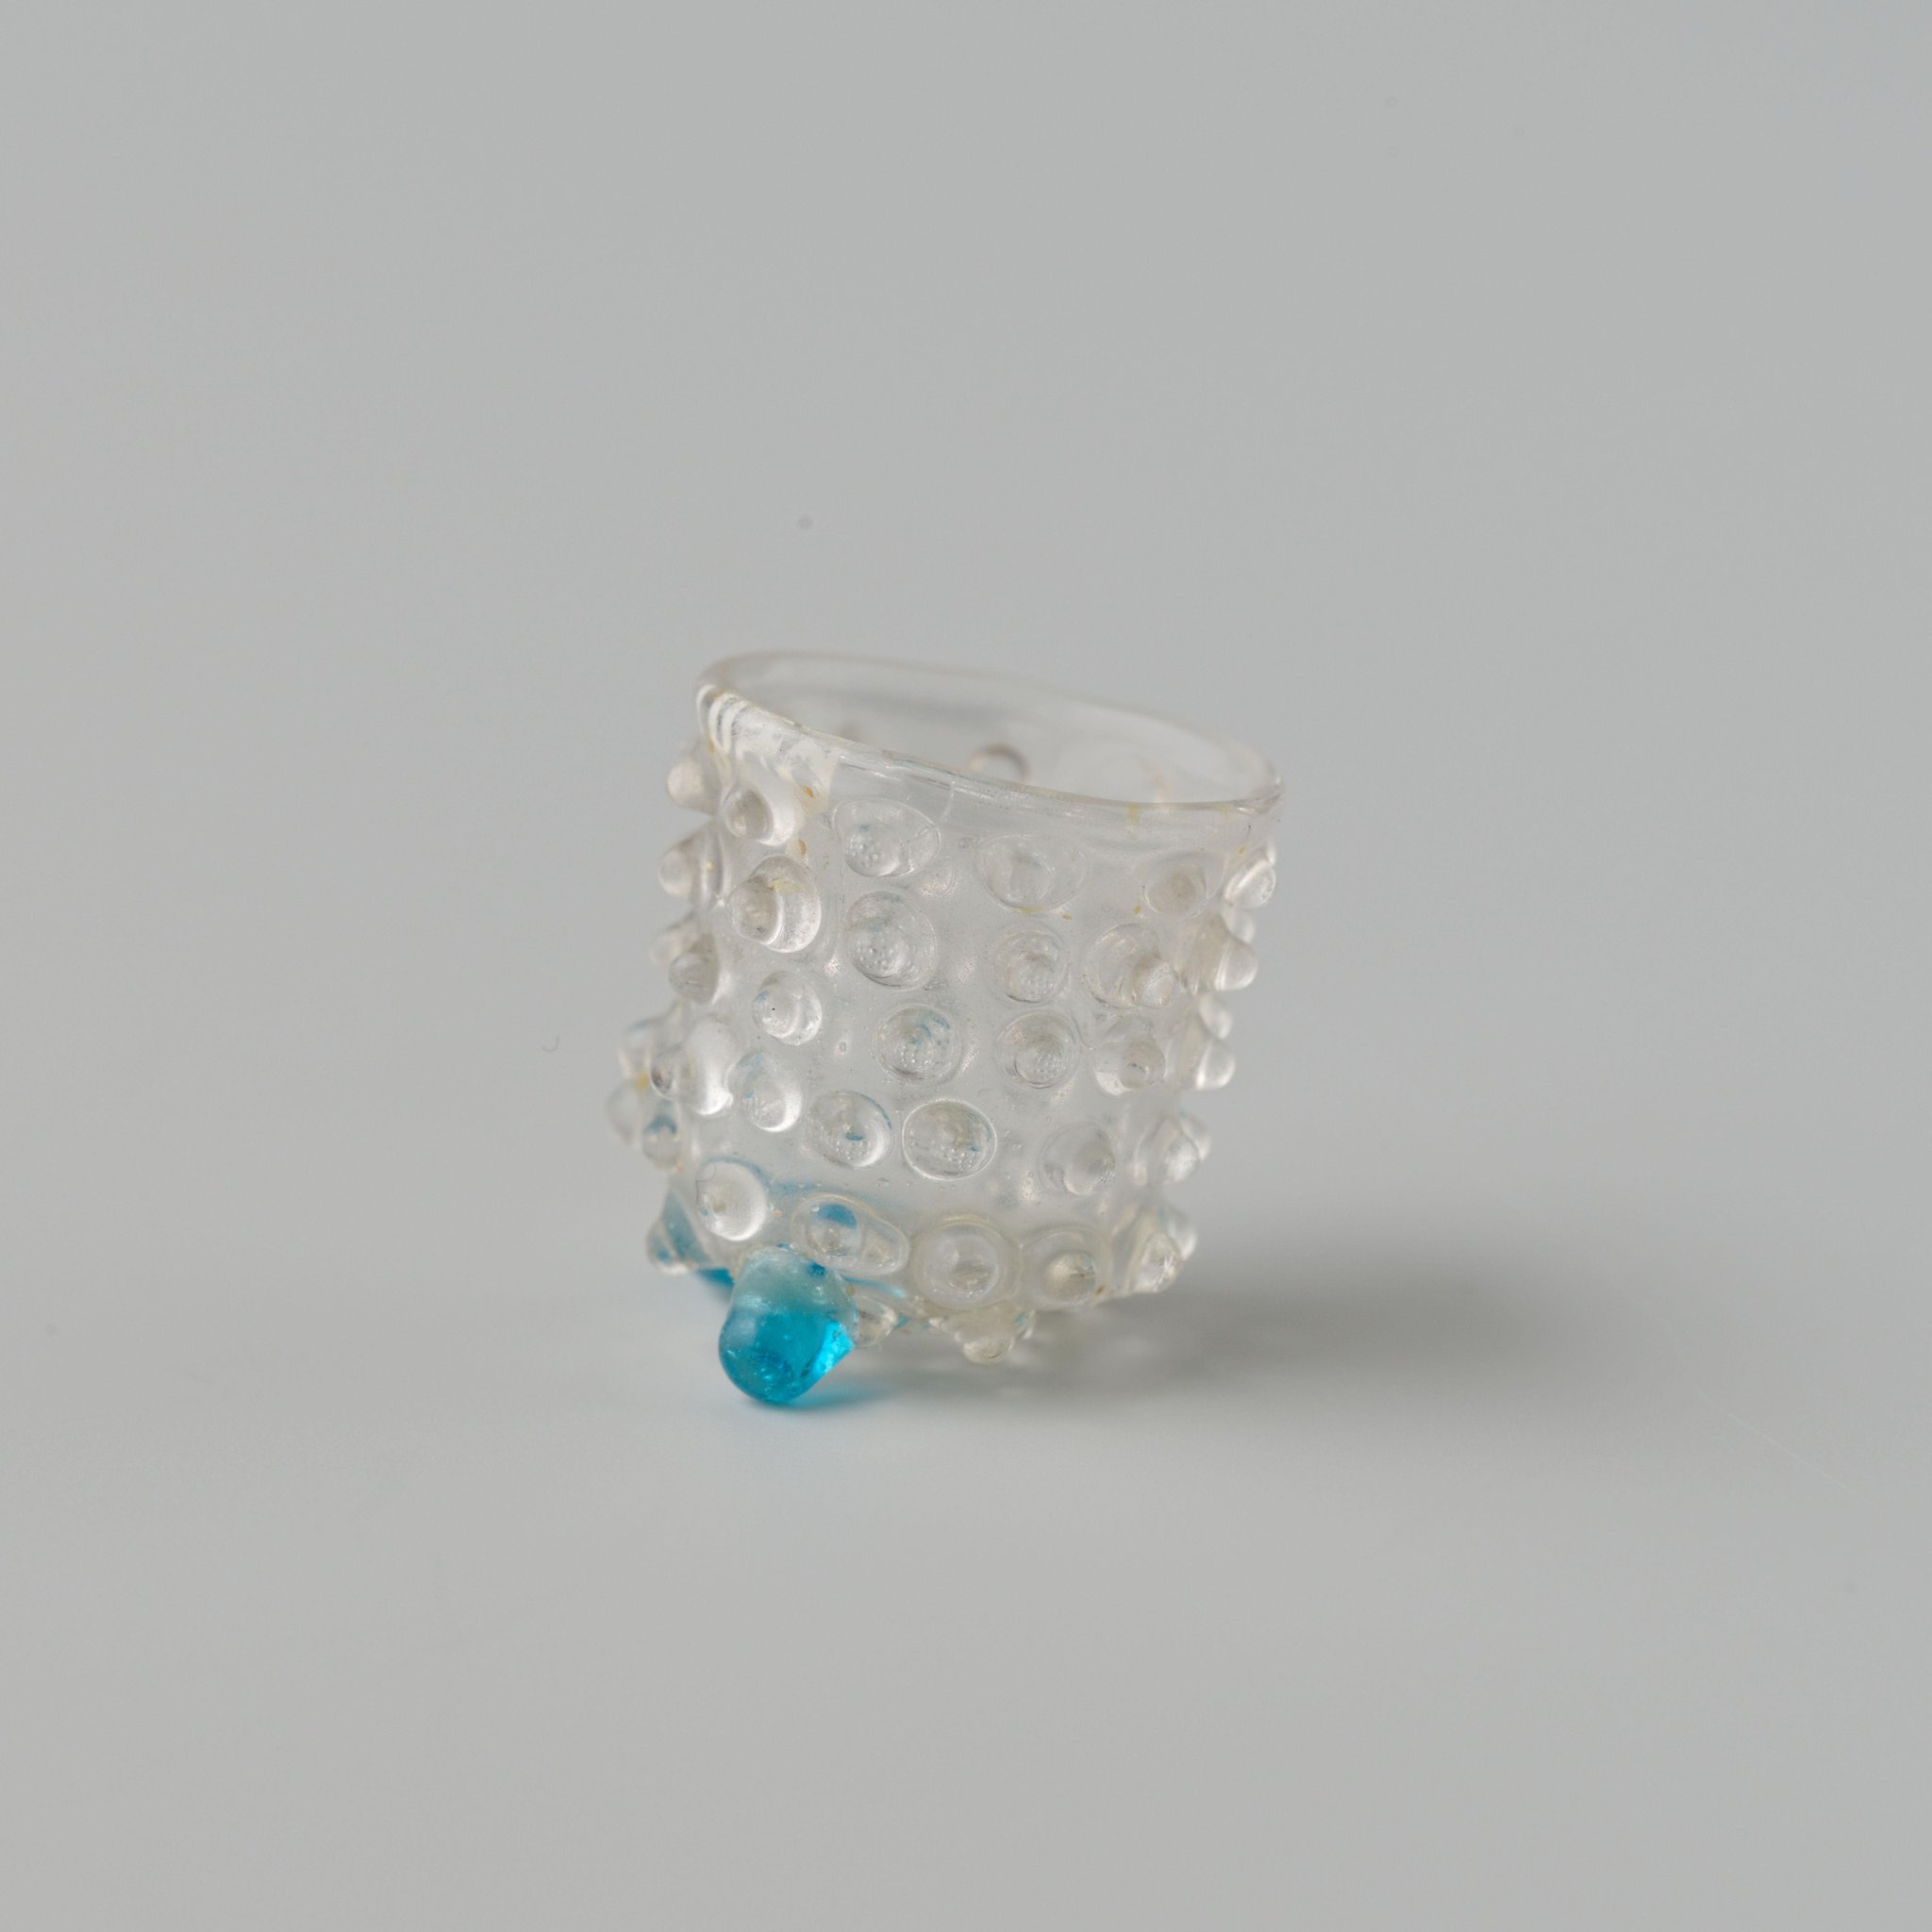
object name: miniature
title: Beker van helder kleurloos glas versierd met noppen staand op drie bolpootjes.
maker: Anonymous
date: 1675-1710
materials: glass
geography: amsterdam